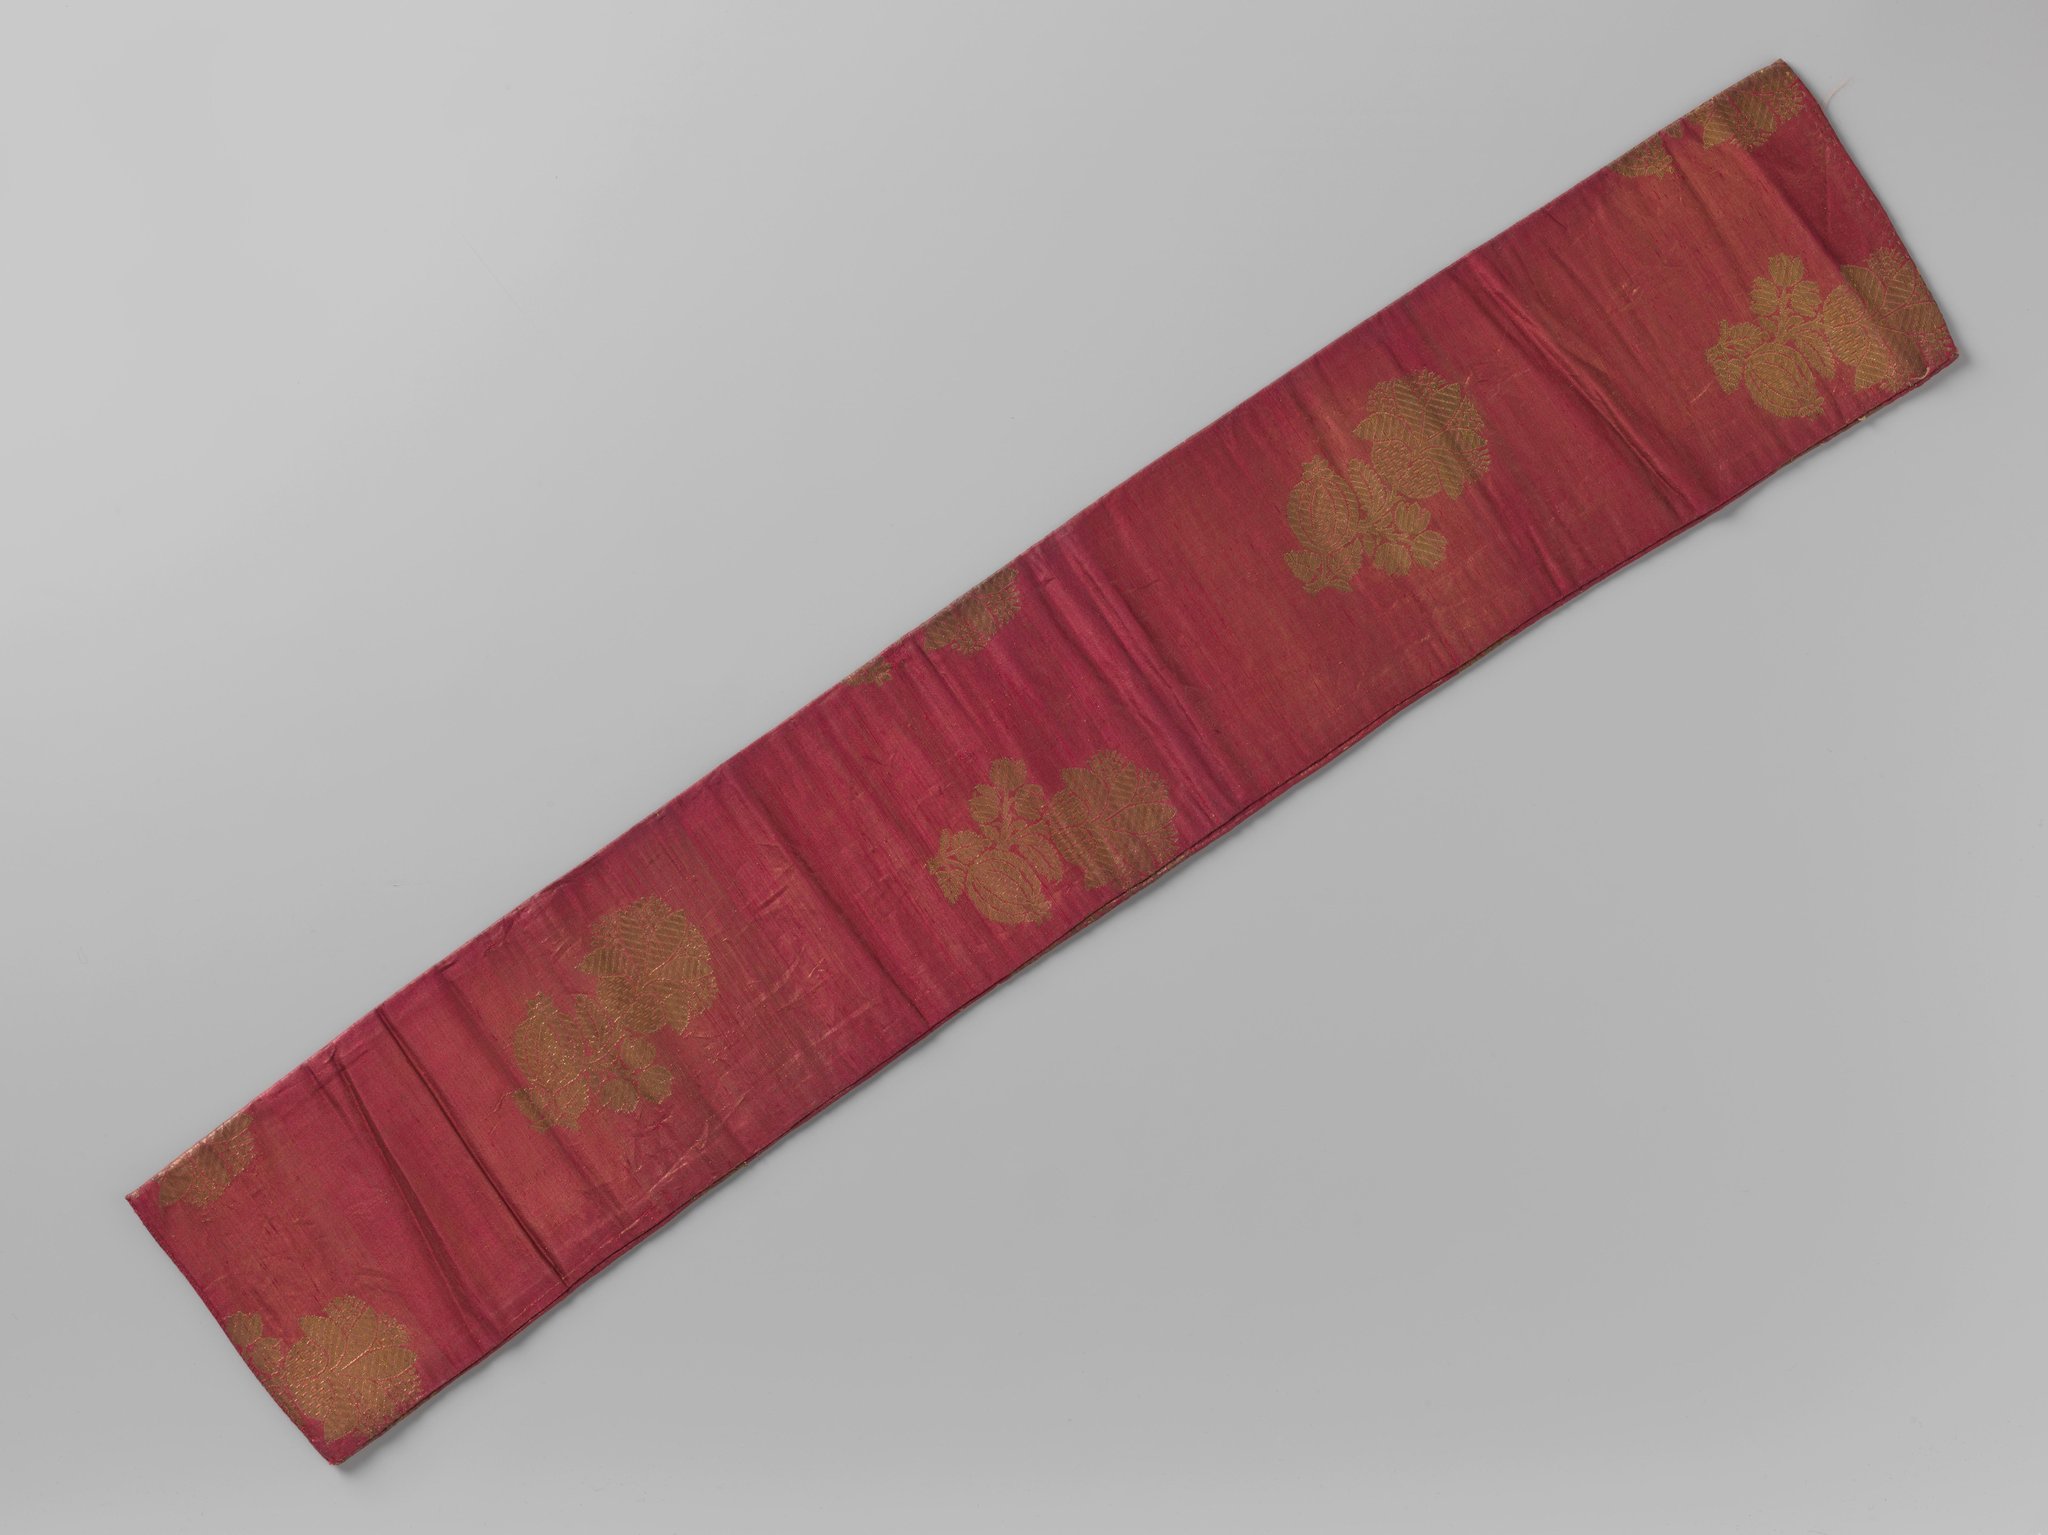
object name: letter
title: Envelop waarin een verslag van Justinus Coljer werd bewaard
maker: Anonymous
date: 1668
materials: silk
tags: justinus coljer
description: Diplomatic stationary, second half 17th century. Special envelopes were used for diplomatic correspondence. The velvet envelope contained a letter (dated 20 September 1686) from the emperor of Morocco to the States General concerning deliveries of weapons from the Republic. The silk envelope contained a letter sent in 1668 by the Dutch representative in Constantinople (Istanbul), Justinus Coljer, to the States General. The painting above shows a Russian diplomatic delegation at the Binnenhof in The Hague bearing a sealed envelope. On loan from Algemeen Rijksarchief, Den Haag